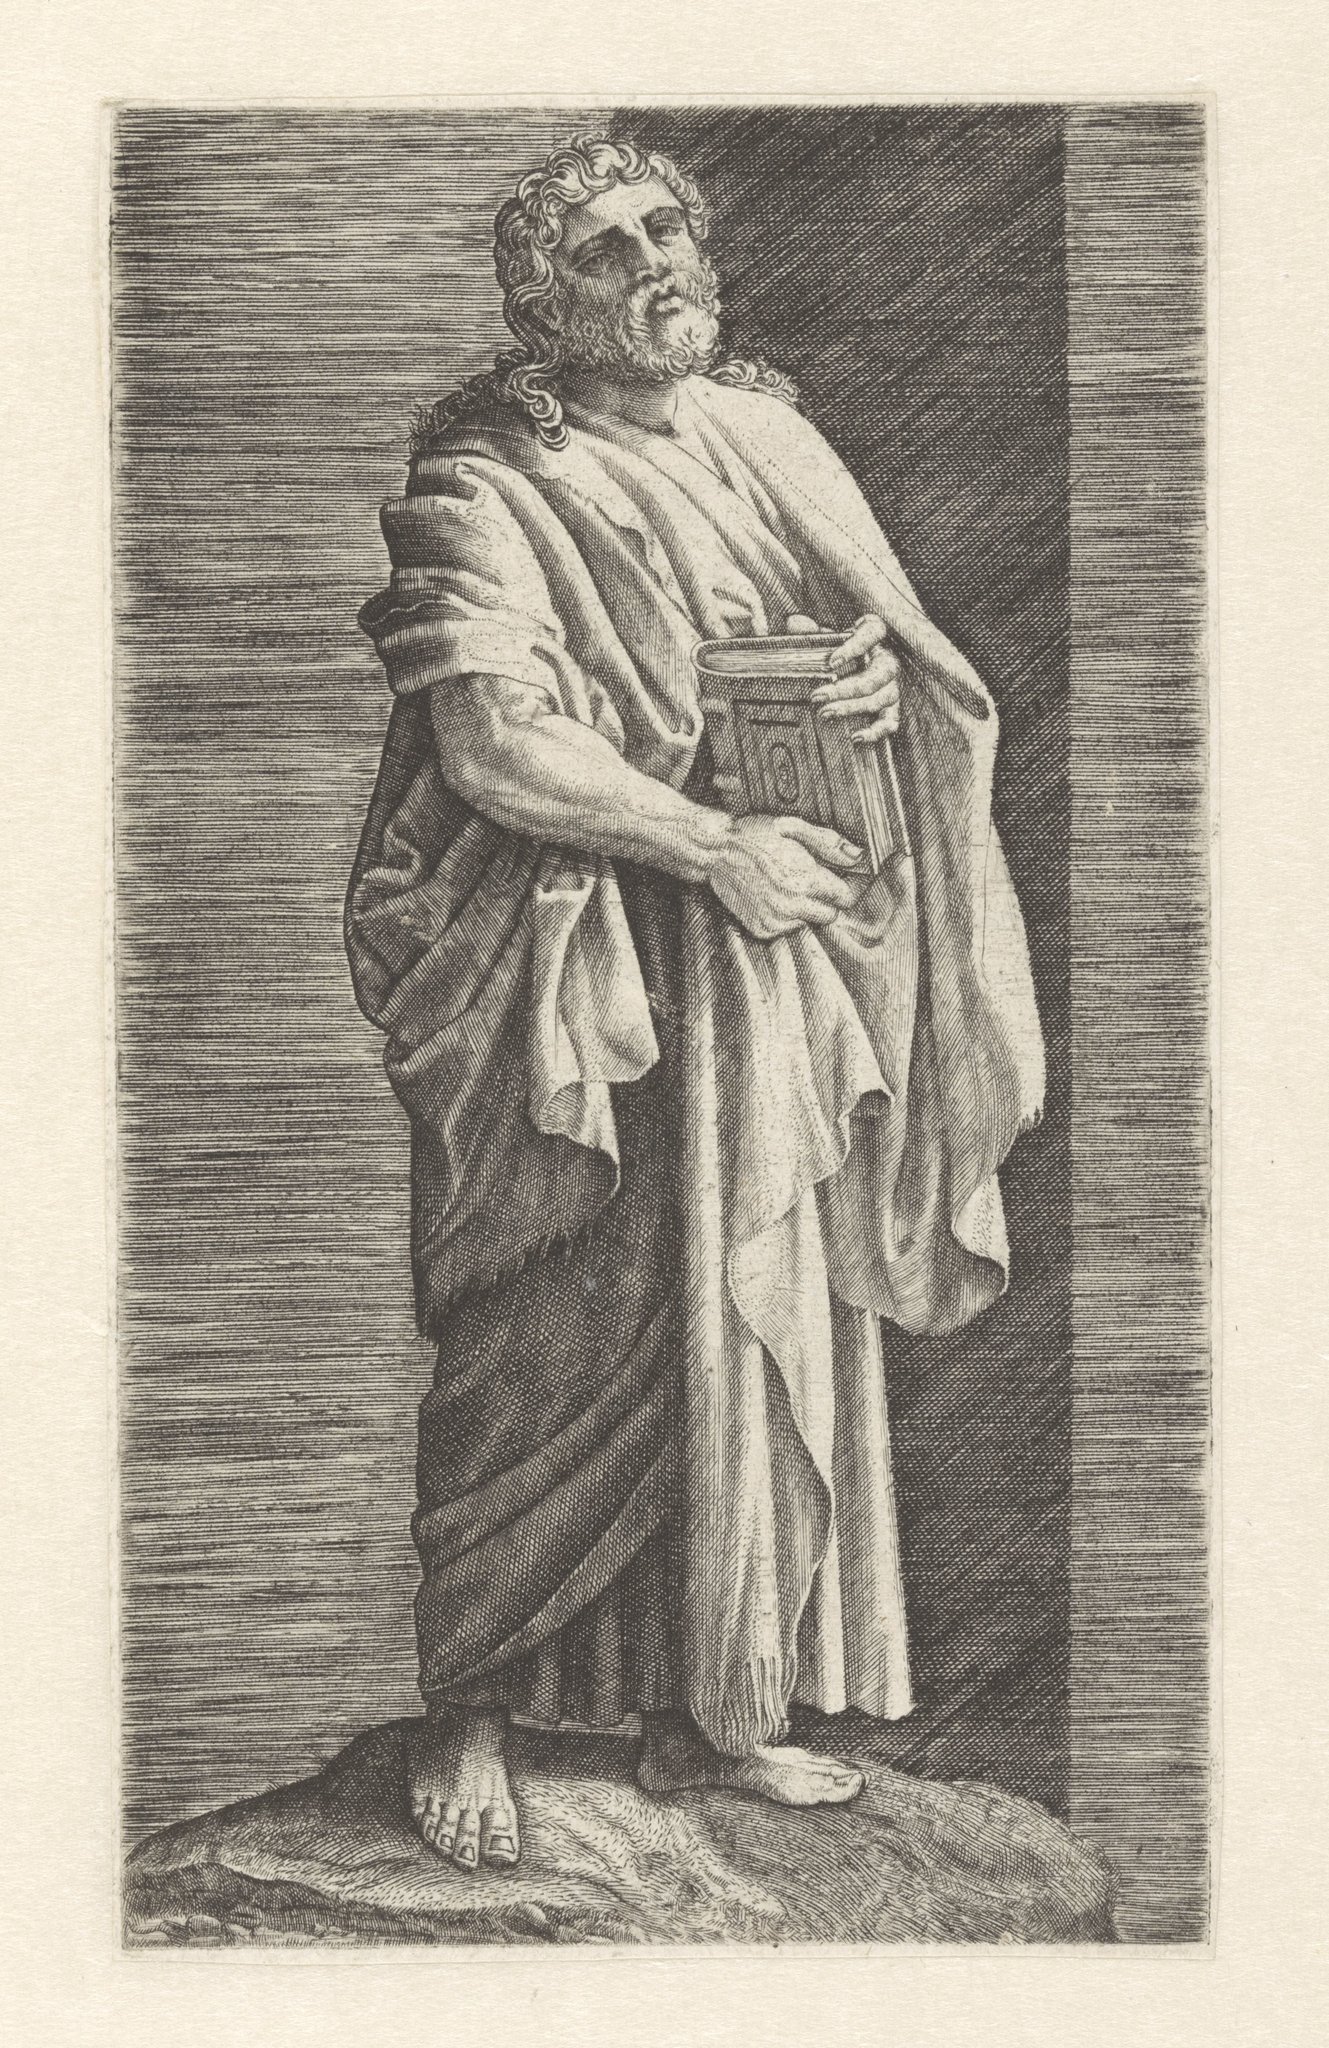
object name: print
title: Christus en twaalf apostelen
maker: Anonymous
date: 1555-1565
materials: paper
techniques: engraving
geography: netherlands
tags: the apostle philip; possible attributes: book, cross, dish with snake, lance, scroll, stone, sword, adult christ together with apostles, evangelists, saints, etc., the twelve apostles (as a group), usually with books or scrolls (not in biblical context)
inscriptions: collector's mark: Lugt 2760, collector's mark: Lugt 2228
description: Slechts één andere, complete serie bekend: in de Koninklijke Bibliotheek te Brussel. Proefdrukken, vóór de opschriften van de namen van Christus en de apostelen.